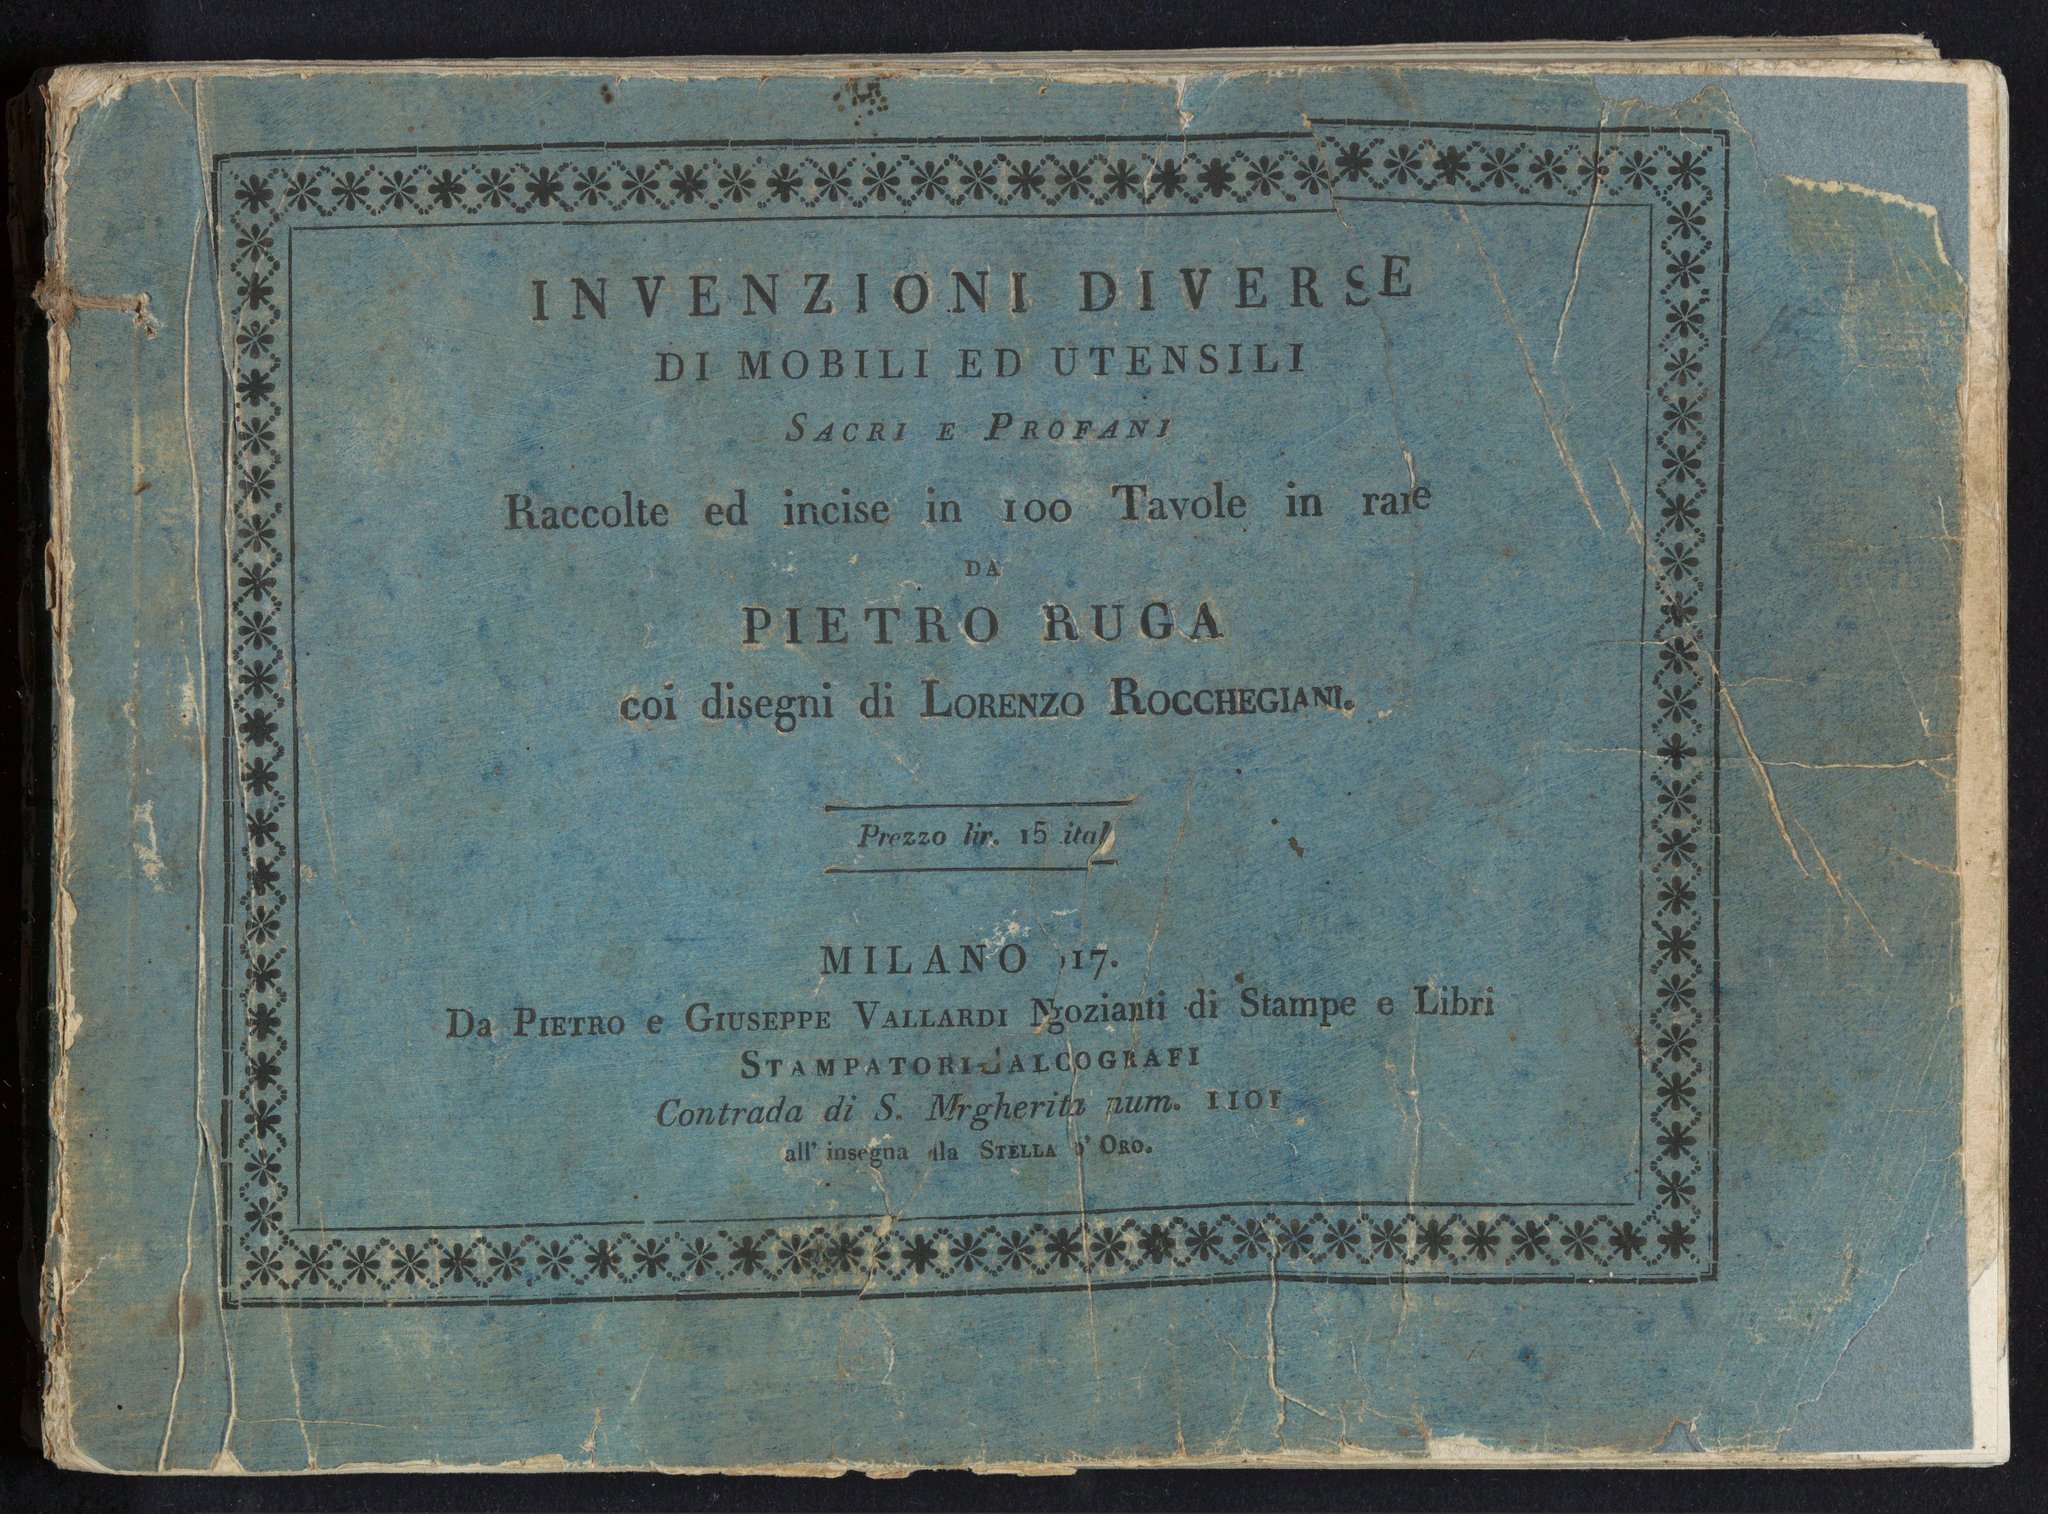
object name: prentrecueil, prentenalbum, prentalbum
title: Album met ontwerpen voor religieuze en profane voorwerpen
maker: pietro ruga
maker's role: print maker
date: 1817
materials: paper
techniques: bookbinding, etching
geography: milan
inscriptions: date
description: Album met een titelprent en 100 etsen van verschillende meubels, vaatwerk, spiegels etc. en ornamentdecoraties. De prenten zijn samengebonden in een omslag van blauw papier. De voorzijde is bedrukt met een titelpagina. De achterzijde bevat een gedrukte fondslijst met titels van architectonische boeken.